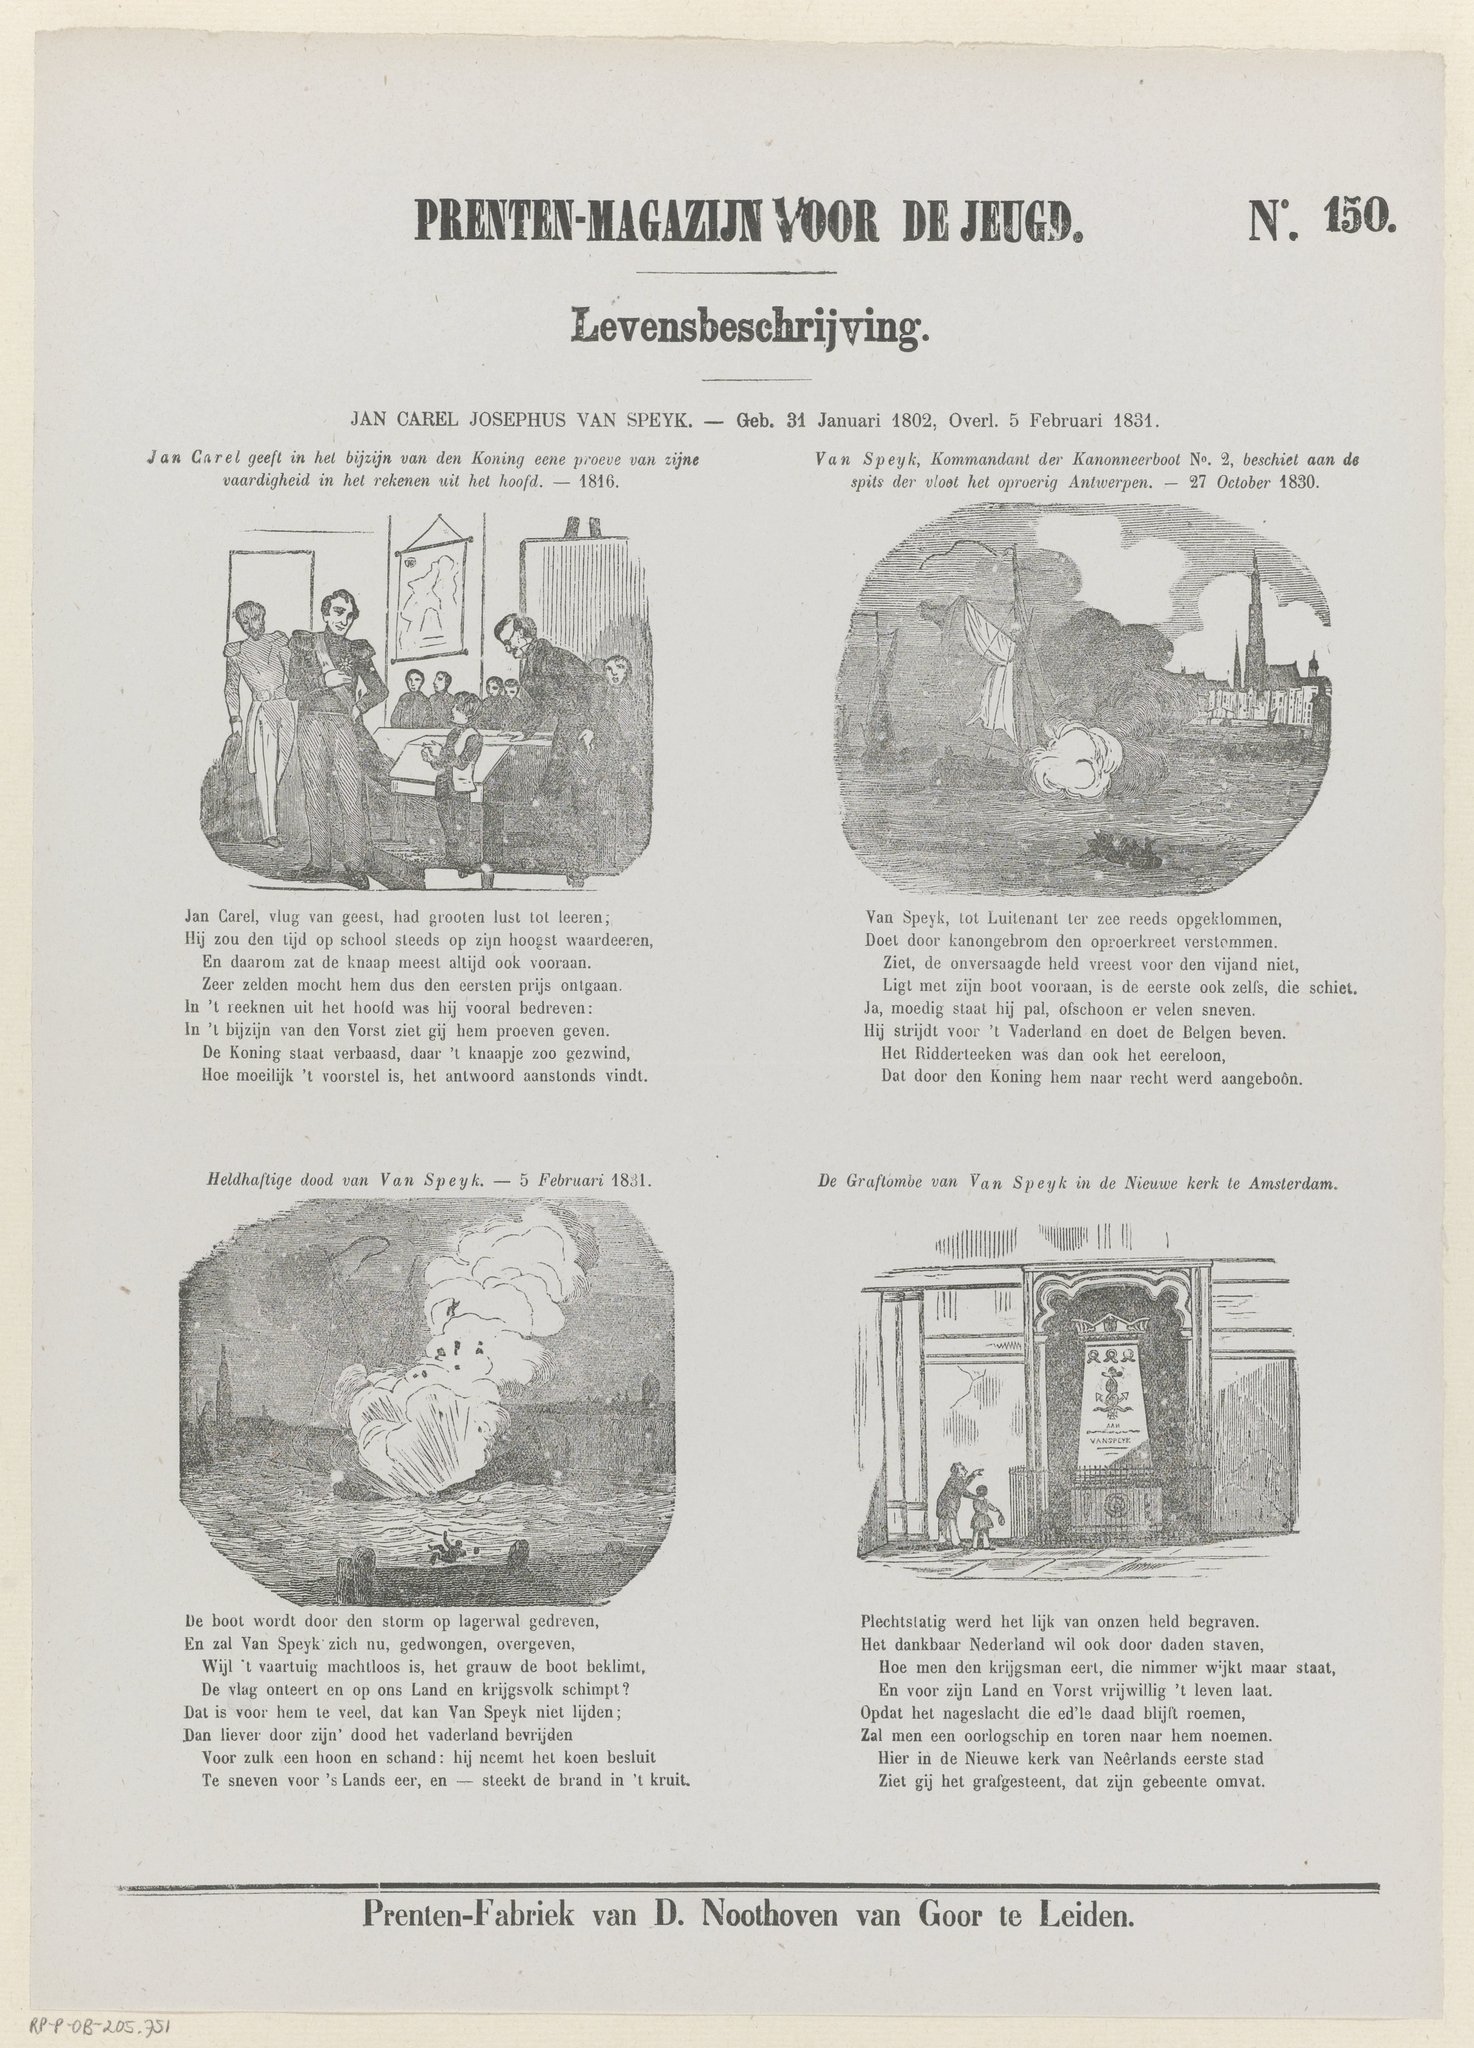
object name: popular print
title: Prenten-magazijn voor de jeugd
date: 1850-1881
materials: paper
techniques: letterpress printing, engraving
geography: netherlands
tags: amsterdam, antwerp, jan van speyk, historical persons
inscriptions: collector's mark: Lugt 2760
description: Blad met 4 voorstellingen uit het leven van Jan Carel Josephus van Speyk. Boven elke voorstelling een titel en onder elke voorstelling een achtregelig vers. Genummerd rechtsboven: No. 150.